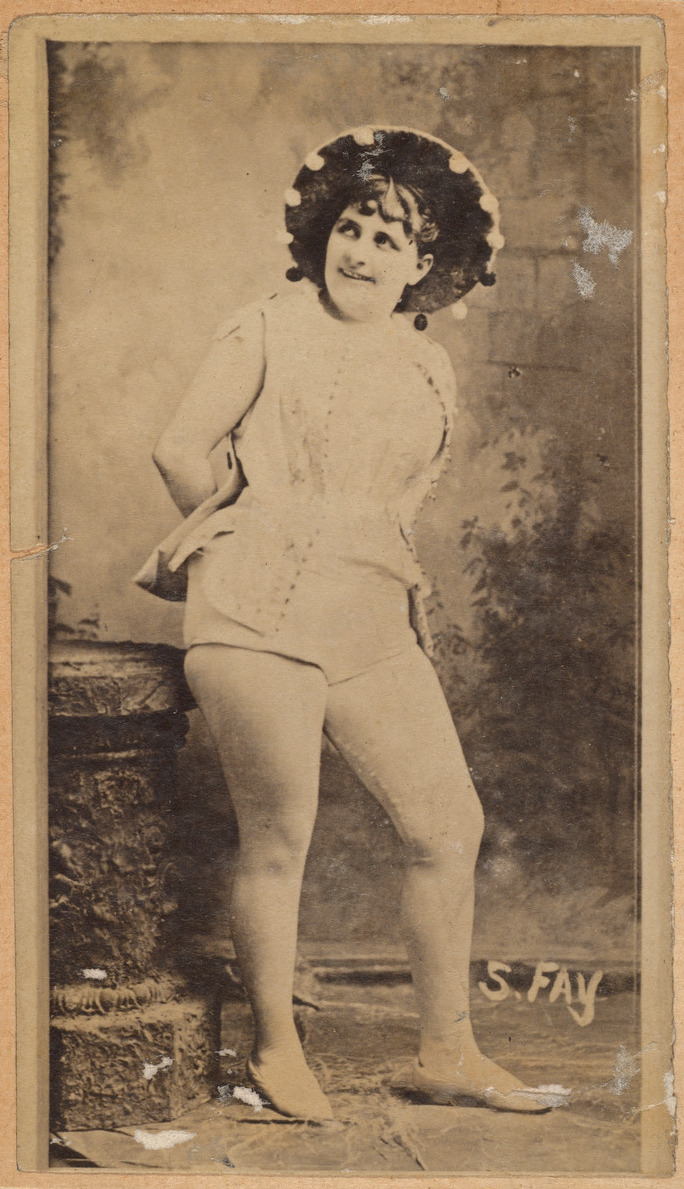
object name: photograph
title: Actress wearing brimmed hat with pompoms, from the Actresses series (N668)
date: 1888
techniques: albumen silver print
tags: portraits,women,actresses